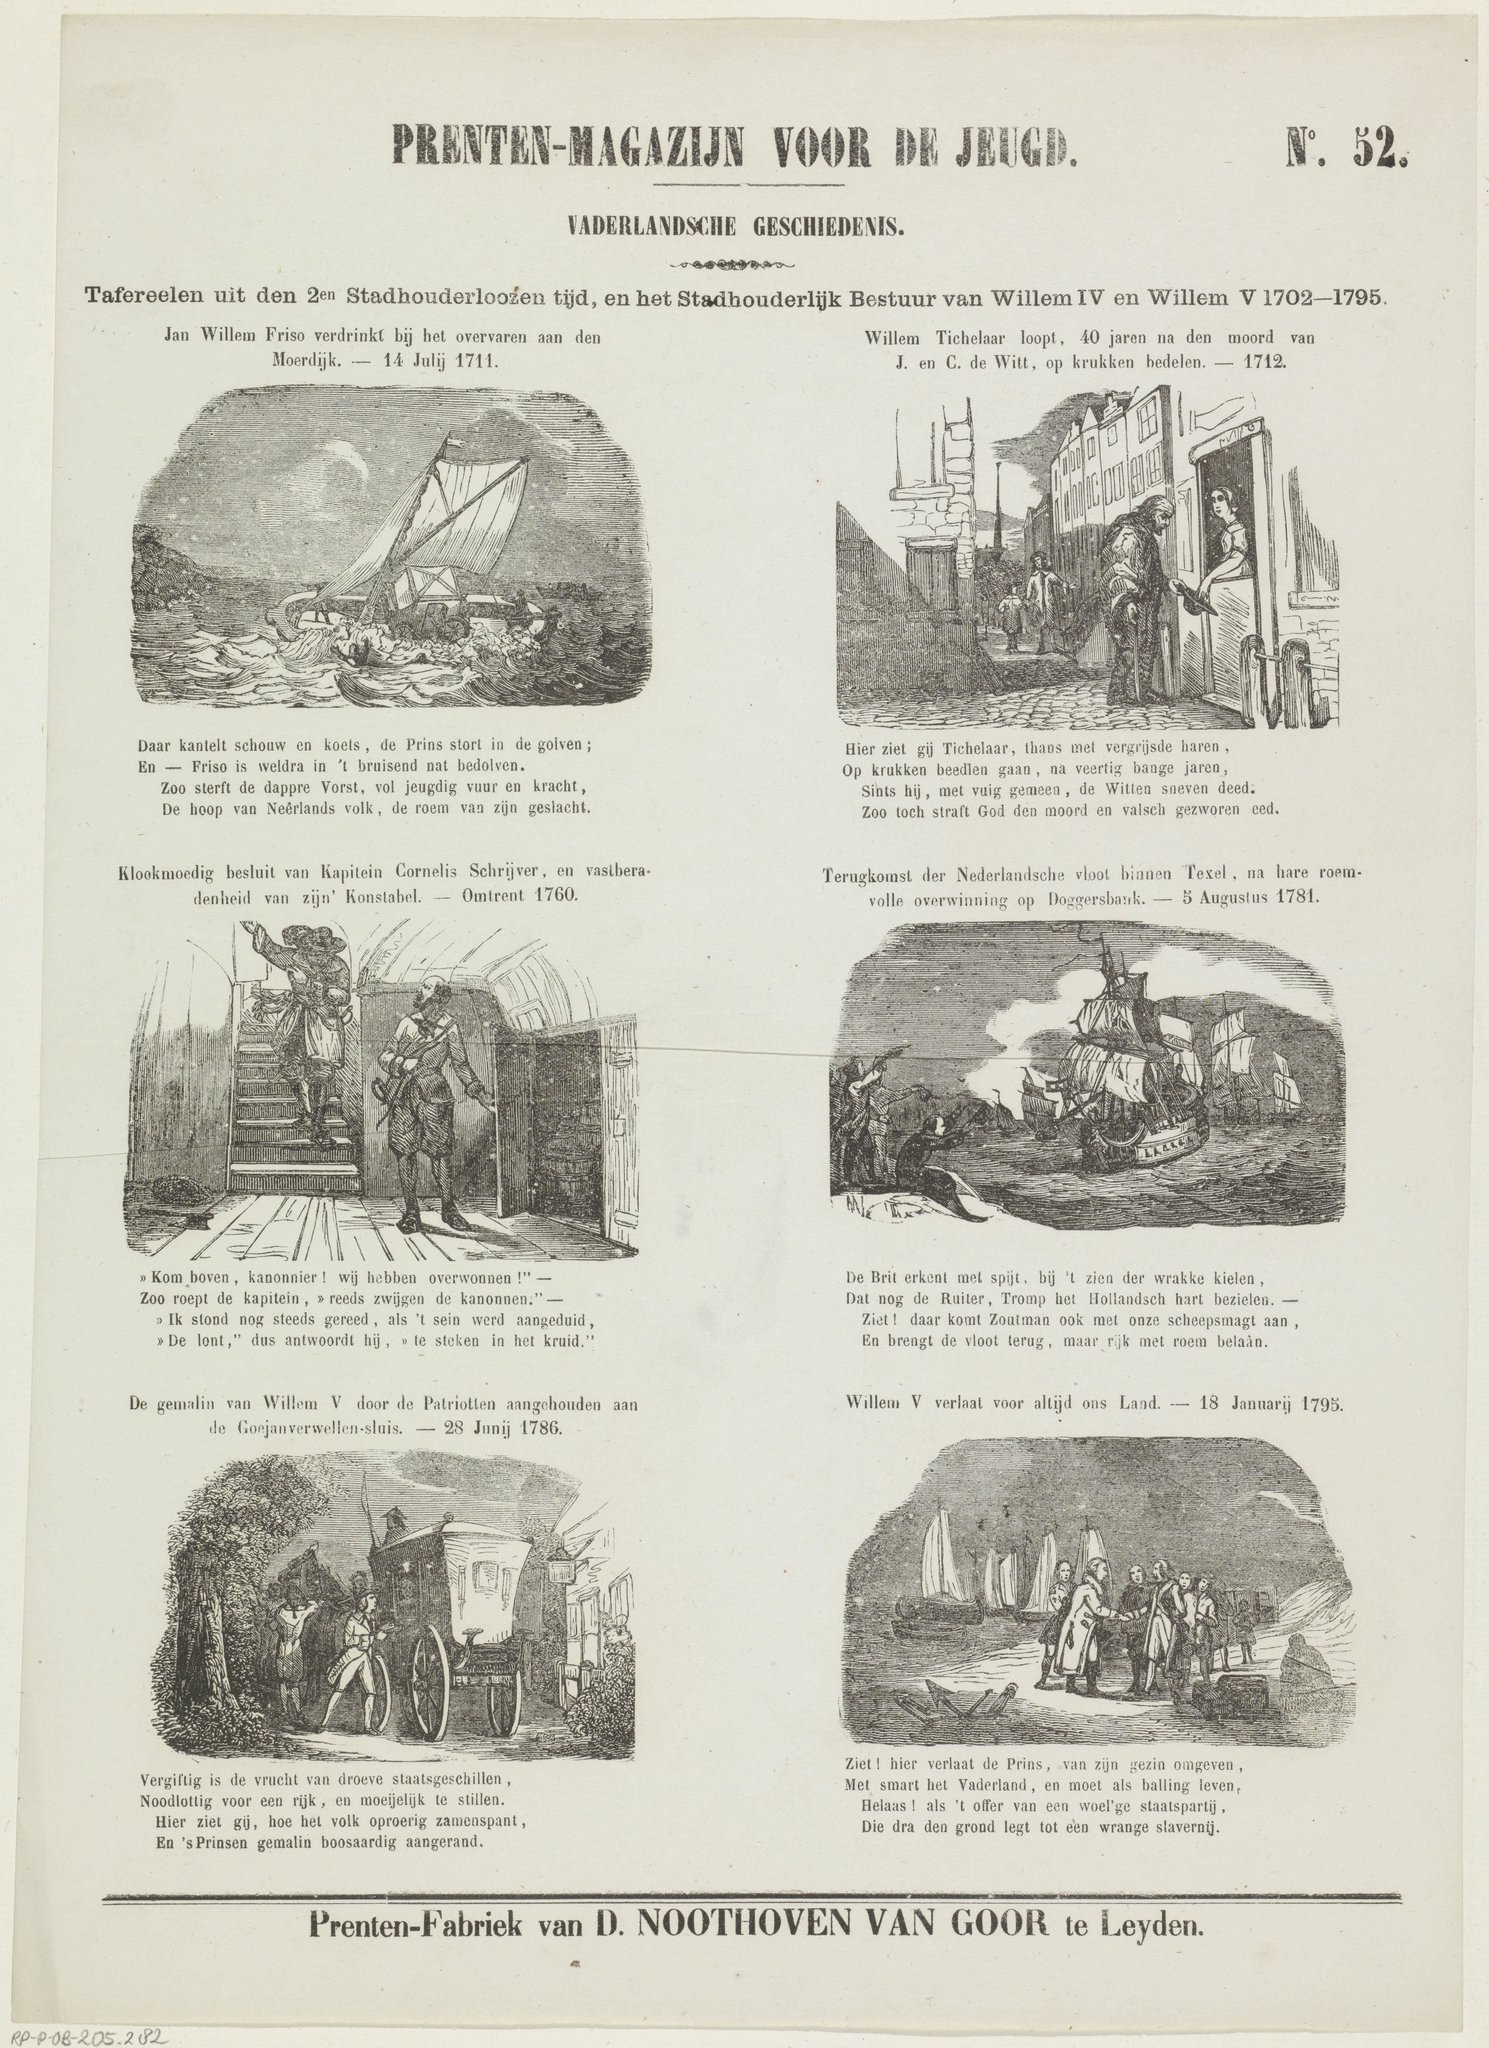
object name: popular print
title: Prenten-magazijn voor de jeugd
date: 1850-1881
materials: paper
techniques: letterpress printing, engraving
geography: leiden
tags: the hague, william v (prince of orange), johan willem friso (prins van oranje-nassau), berlin, painter, draughtsman, wilhelmina of prussia (princess of orange), history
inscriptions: collector's mark: Lugt 2760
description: Blad met 6 voorstellingen van gebeurtenissen ten tijde van het Tweede Stadhouderloze Tijdperk tussen 1702 en 1795. Boven elke voorstelling een titel en onder elke voorstelling een vierregelig vers. Genummerd rechtsboven: No. 52.